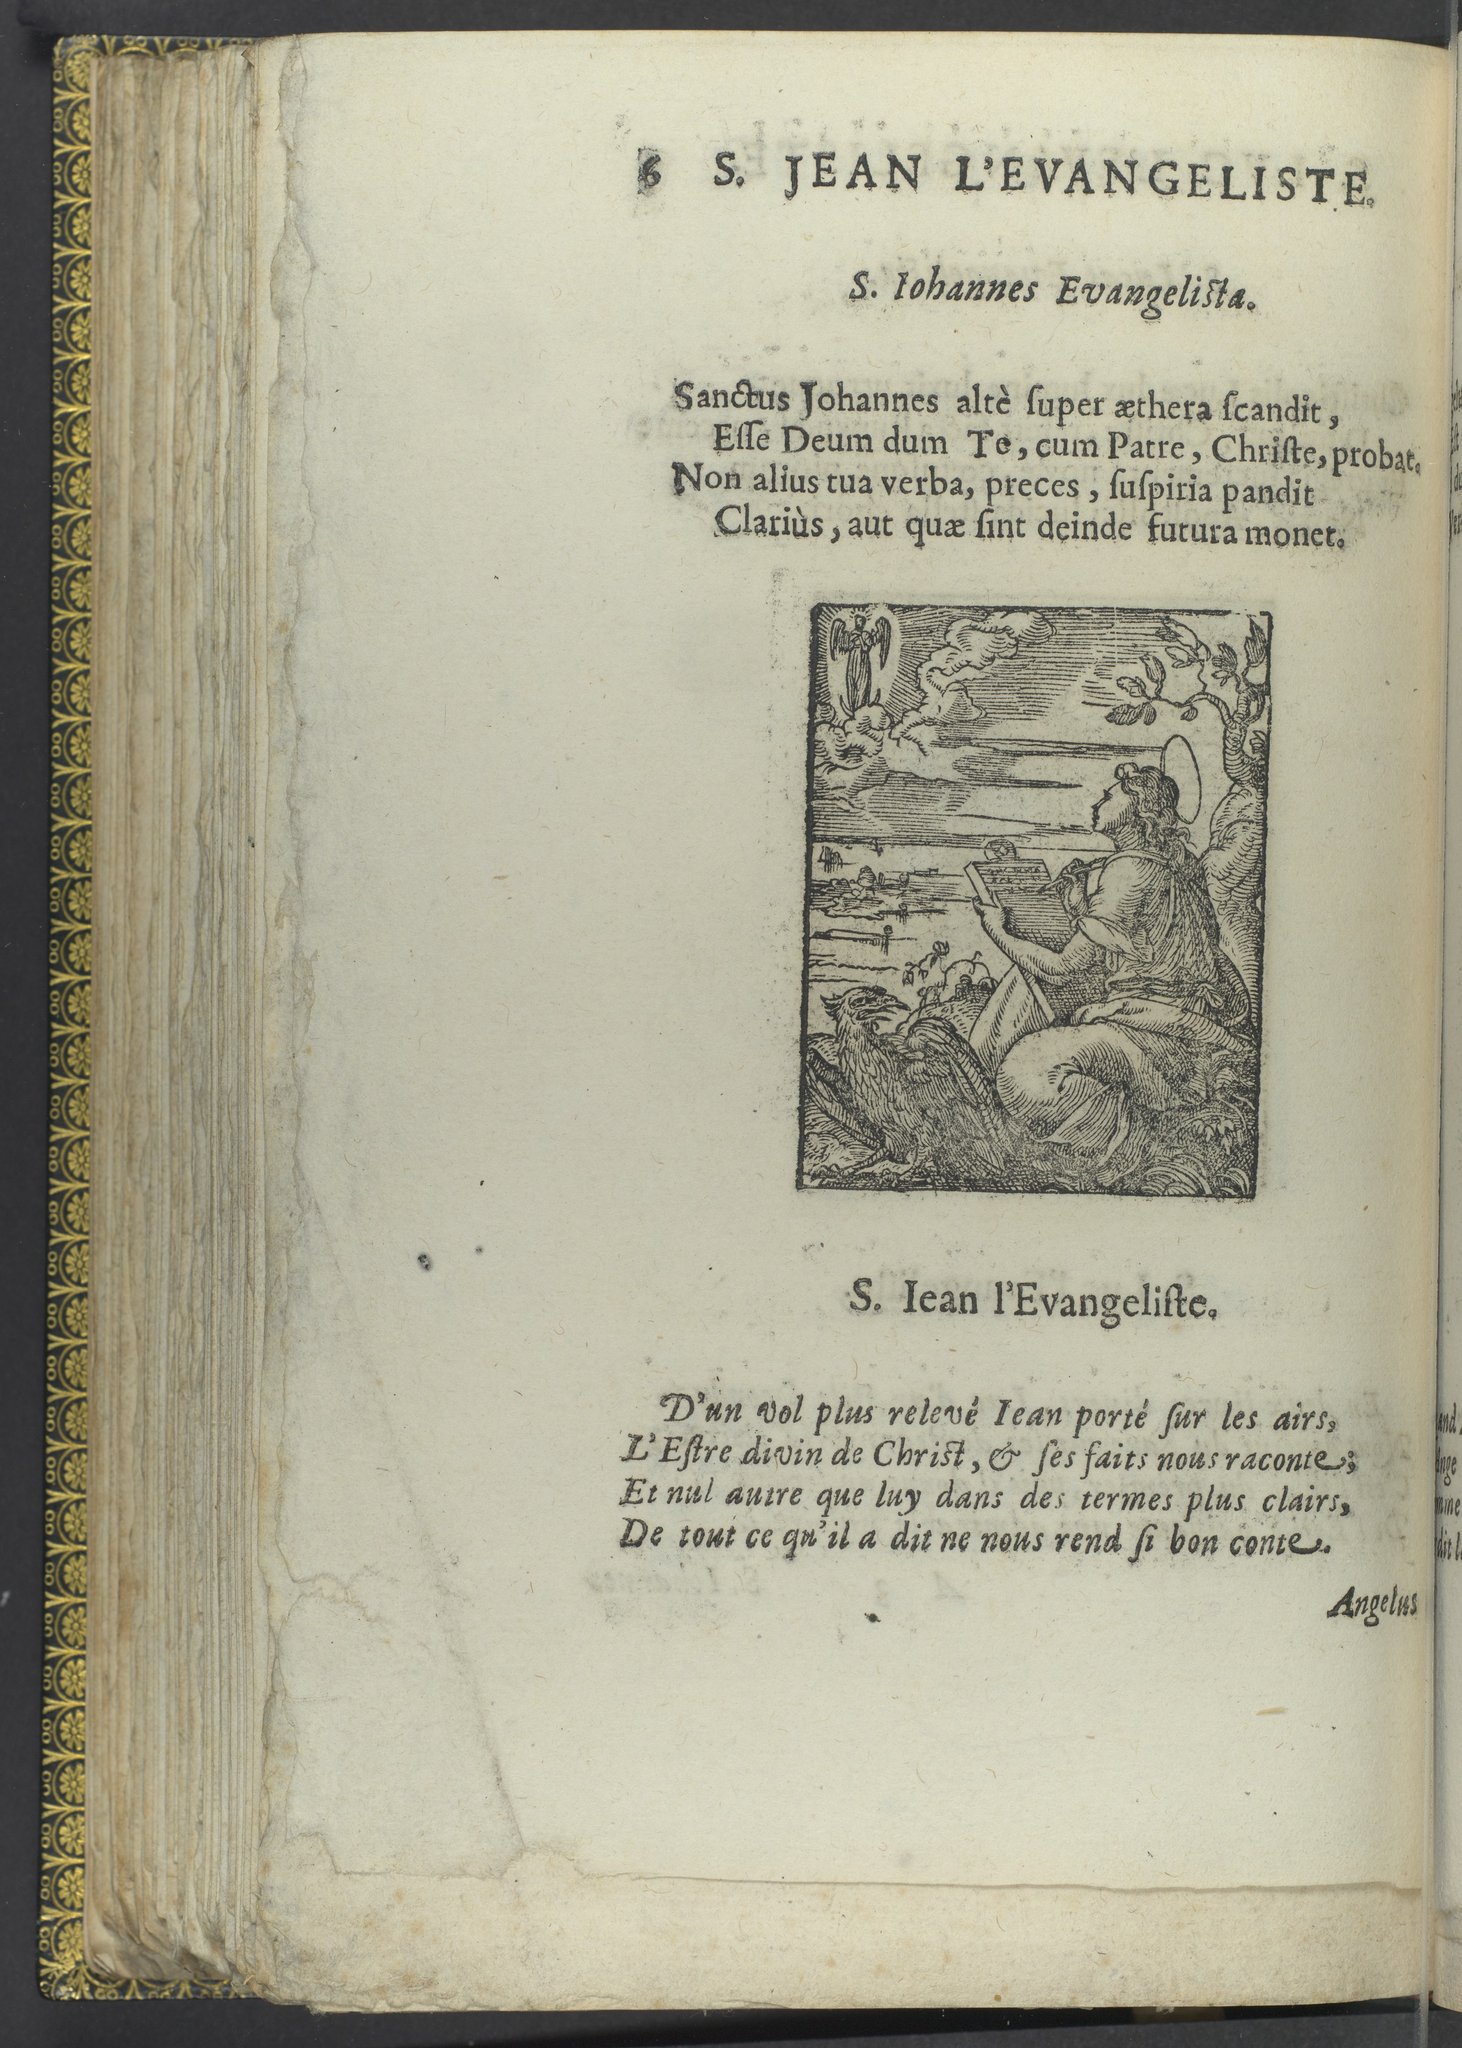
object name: book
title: Icones historicae Veteris et Novi Testament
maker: bernard salomon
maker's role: artist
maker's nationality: french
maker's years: 1508-1561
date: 1681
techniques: woodcut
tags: abel,cain,moses,adam,eve,bible